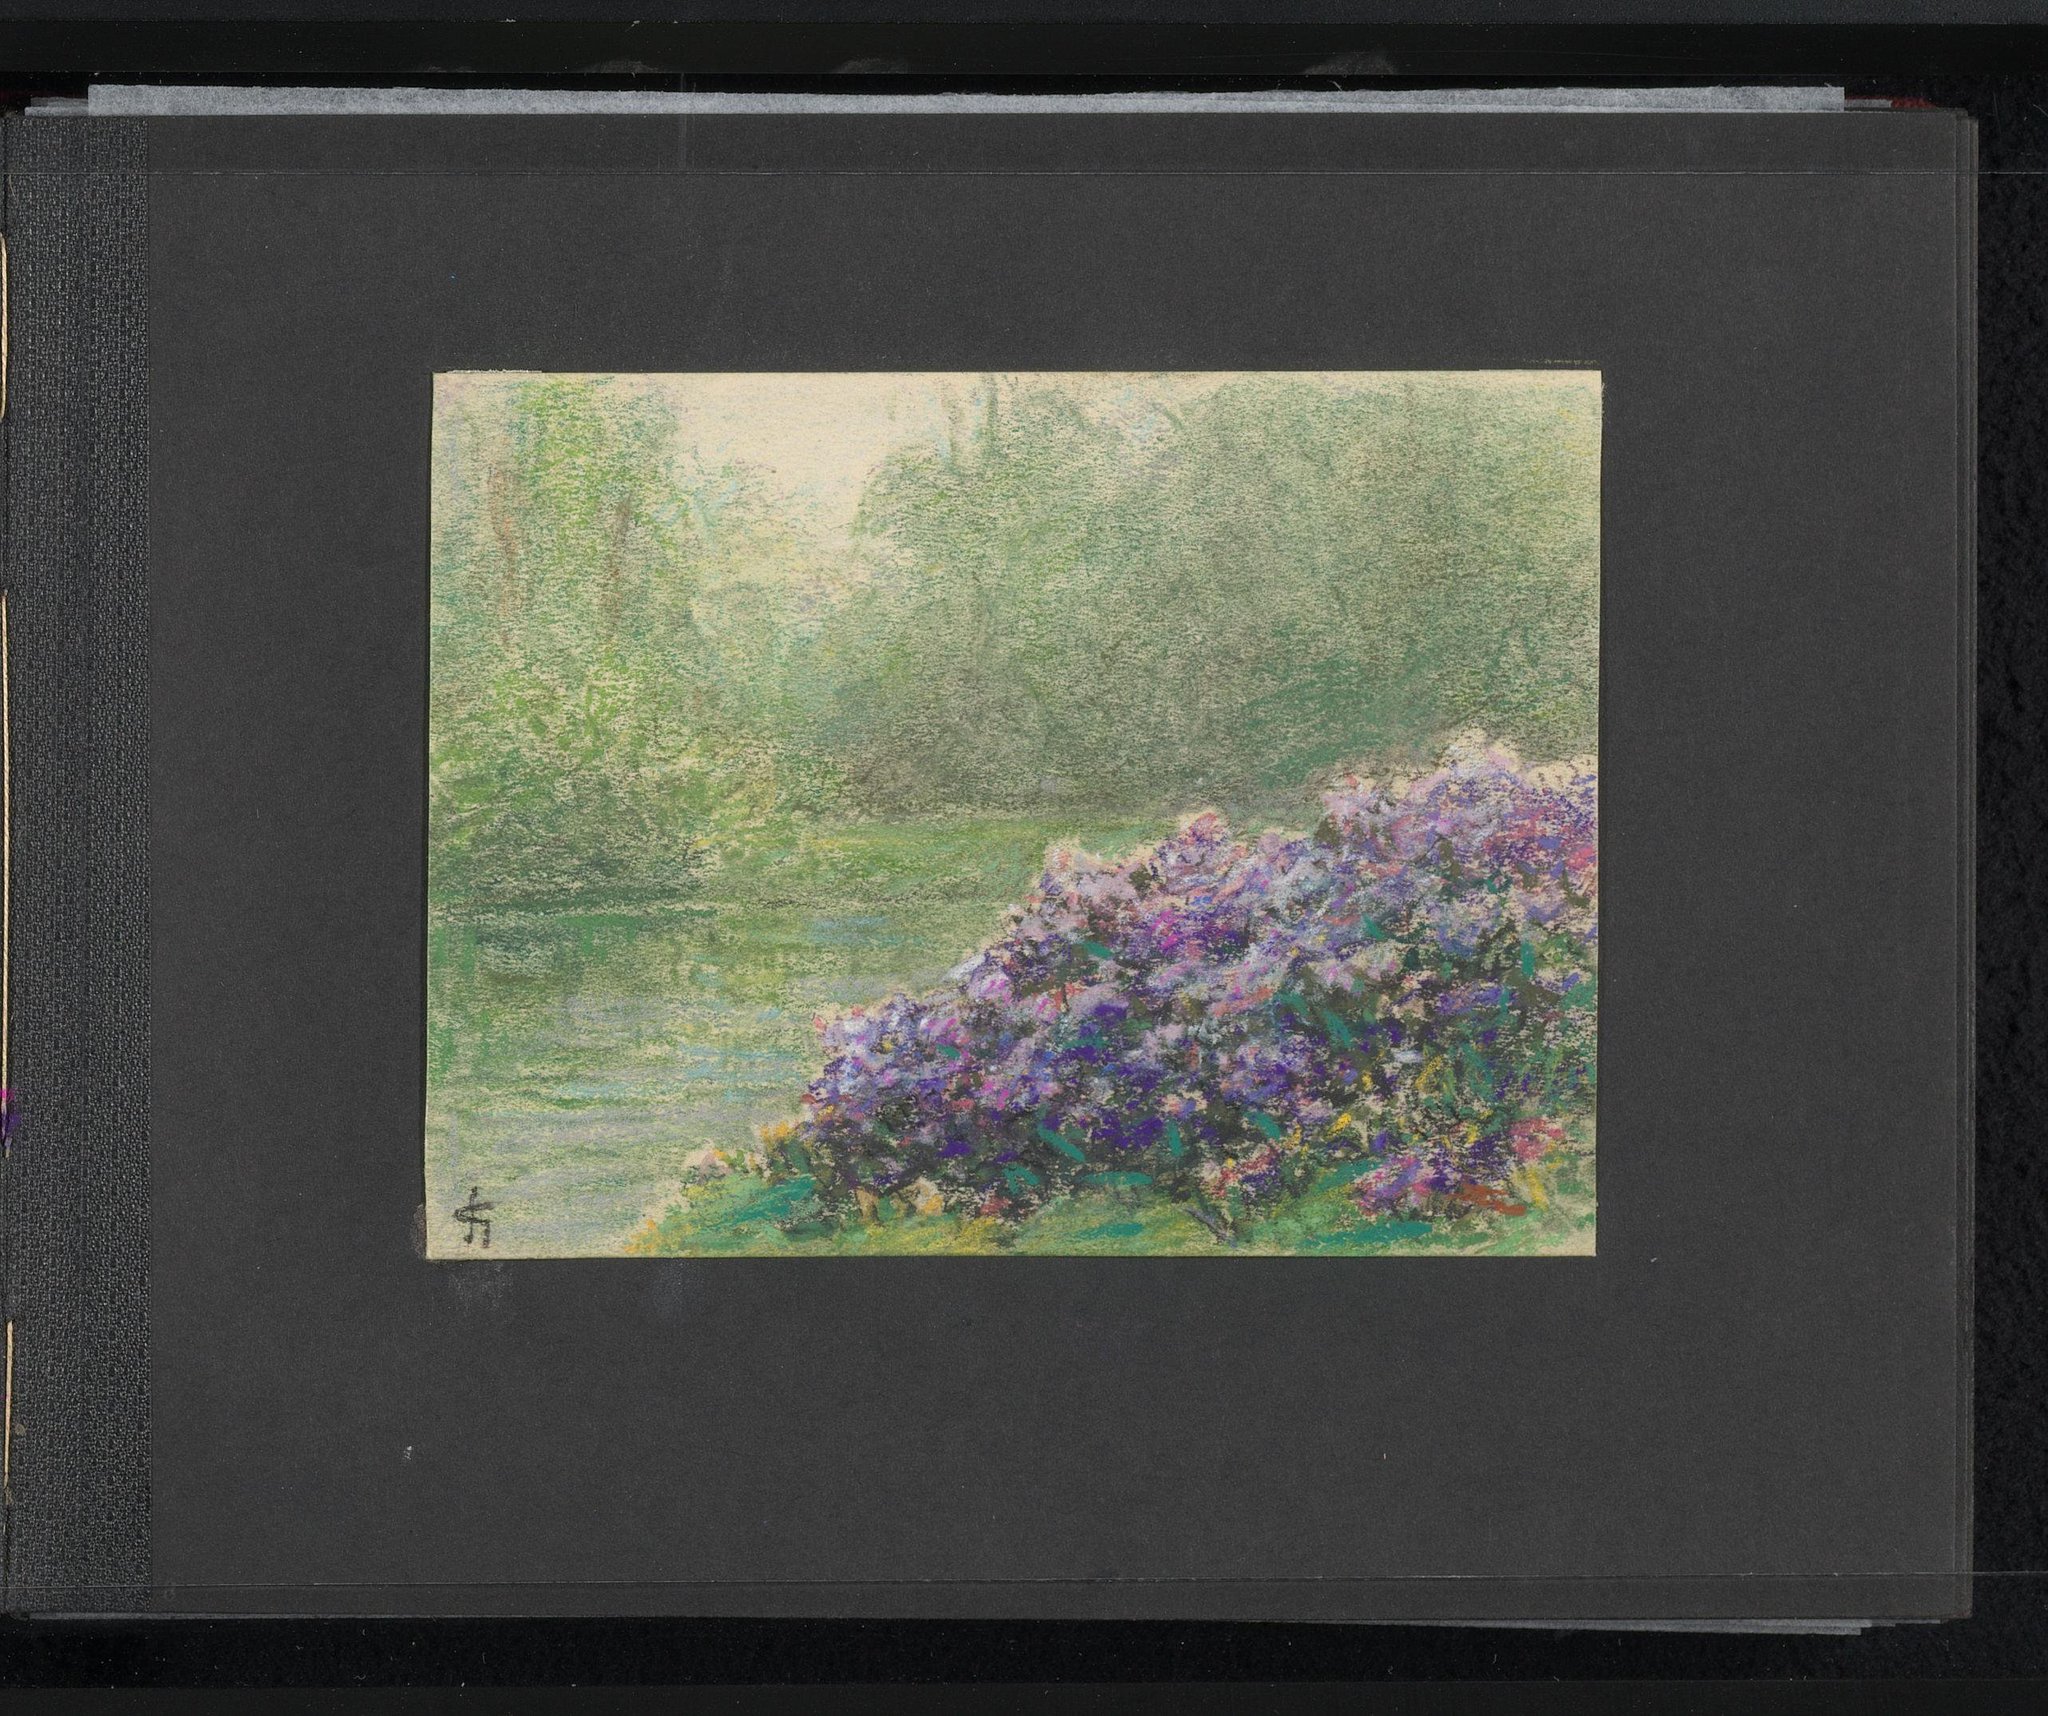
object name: album leaf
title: Waterkant met bloemen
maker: carel nicolaas storm van s-gravesande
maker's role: draughtsman, print maker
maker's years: 1841-1924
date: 1915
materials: chalk, paper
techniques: pasting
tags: flowers, garden pond, public gardens, park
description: Waarschijnlijk te Wiesbaden. Tekening maakt deel uit van een album.